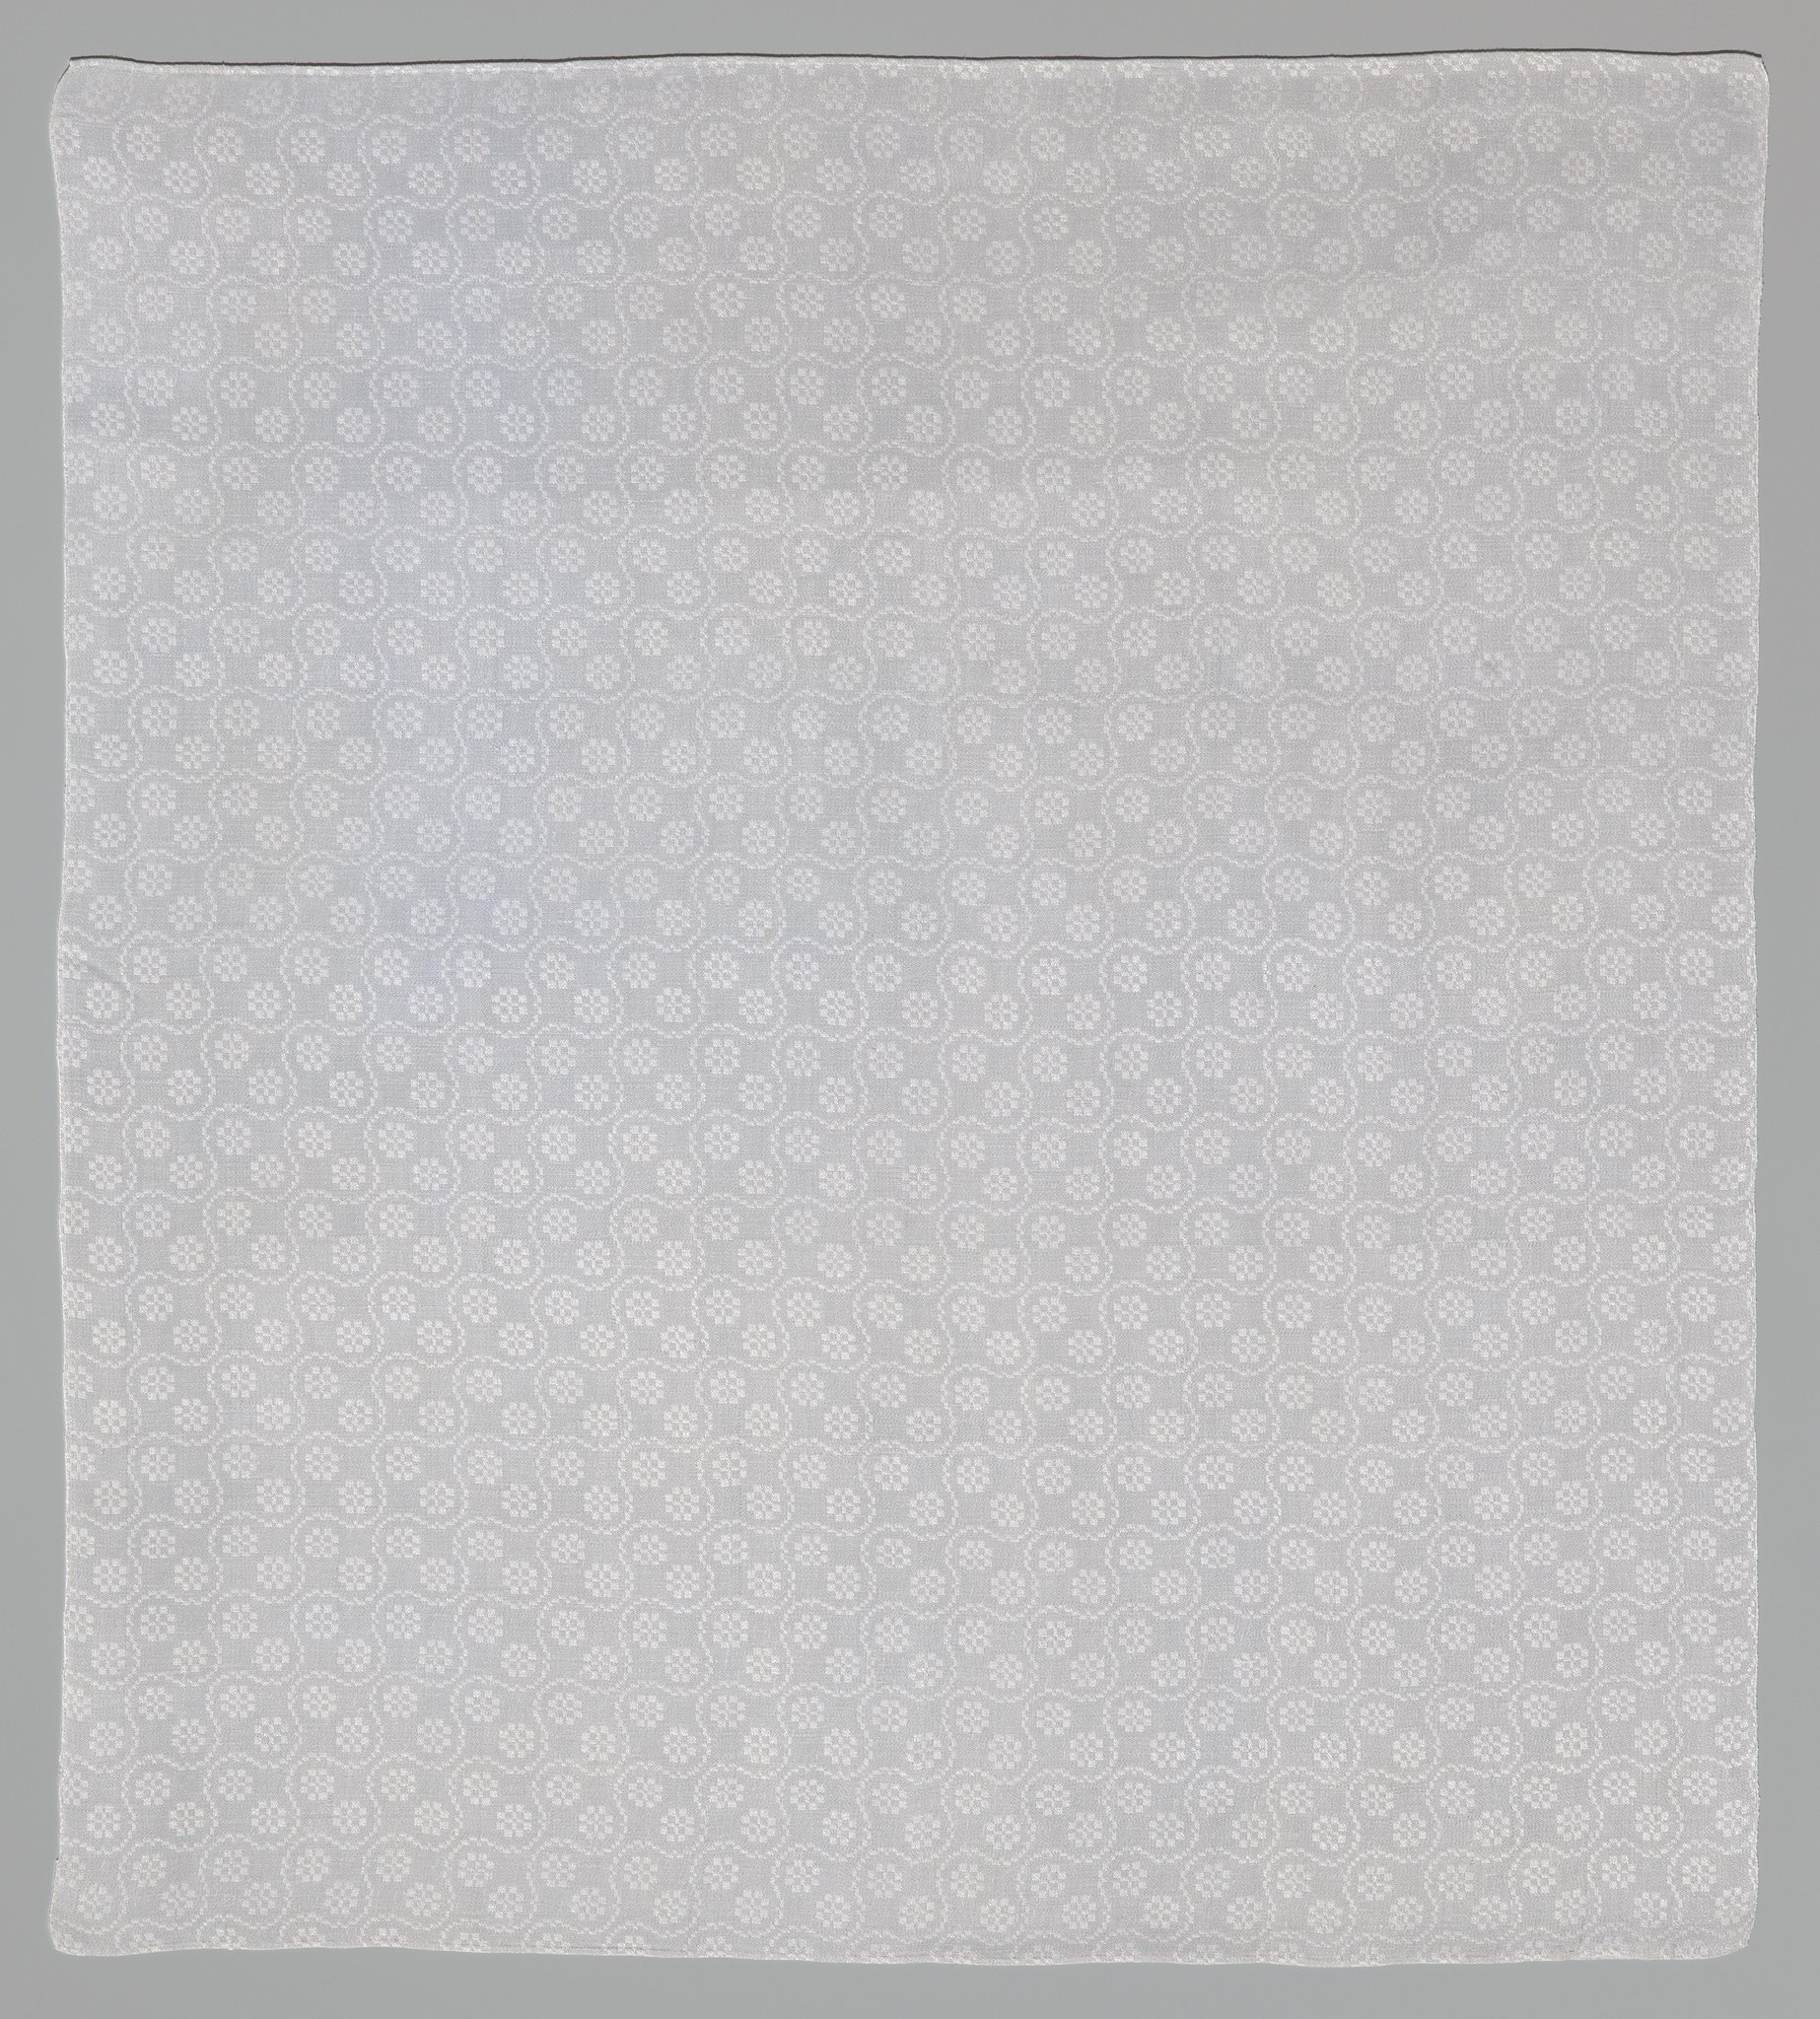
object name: napkin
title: Servet van linnen met pellenpatroon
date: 1800-1870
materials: linen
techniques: peeled fabric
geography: northern netherlands